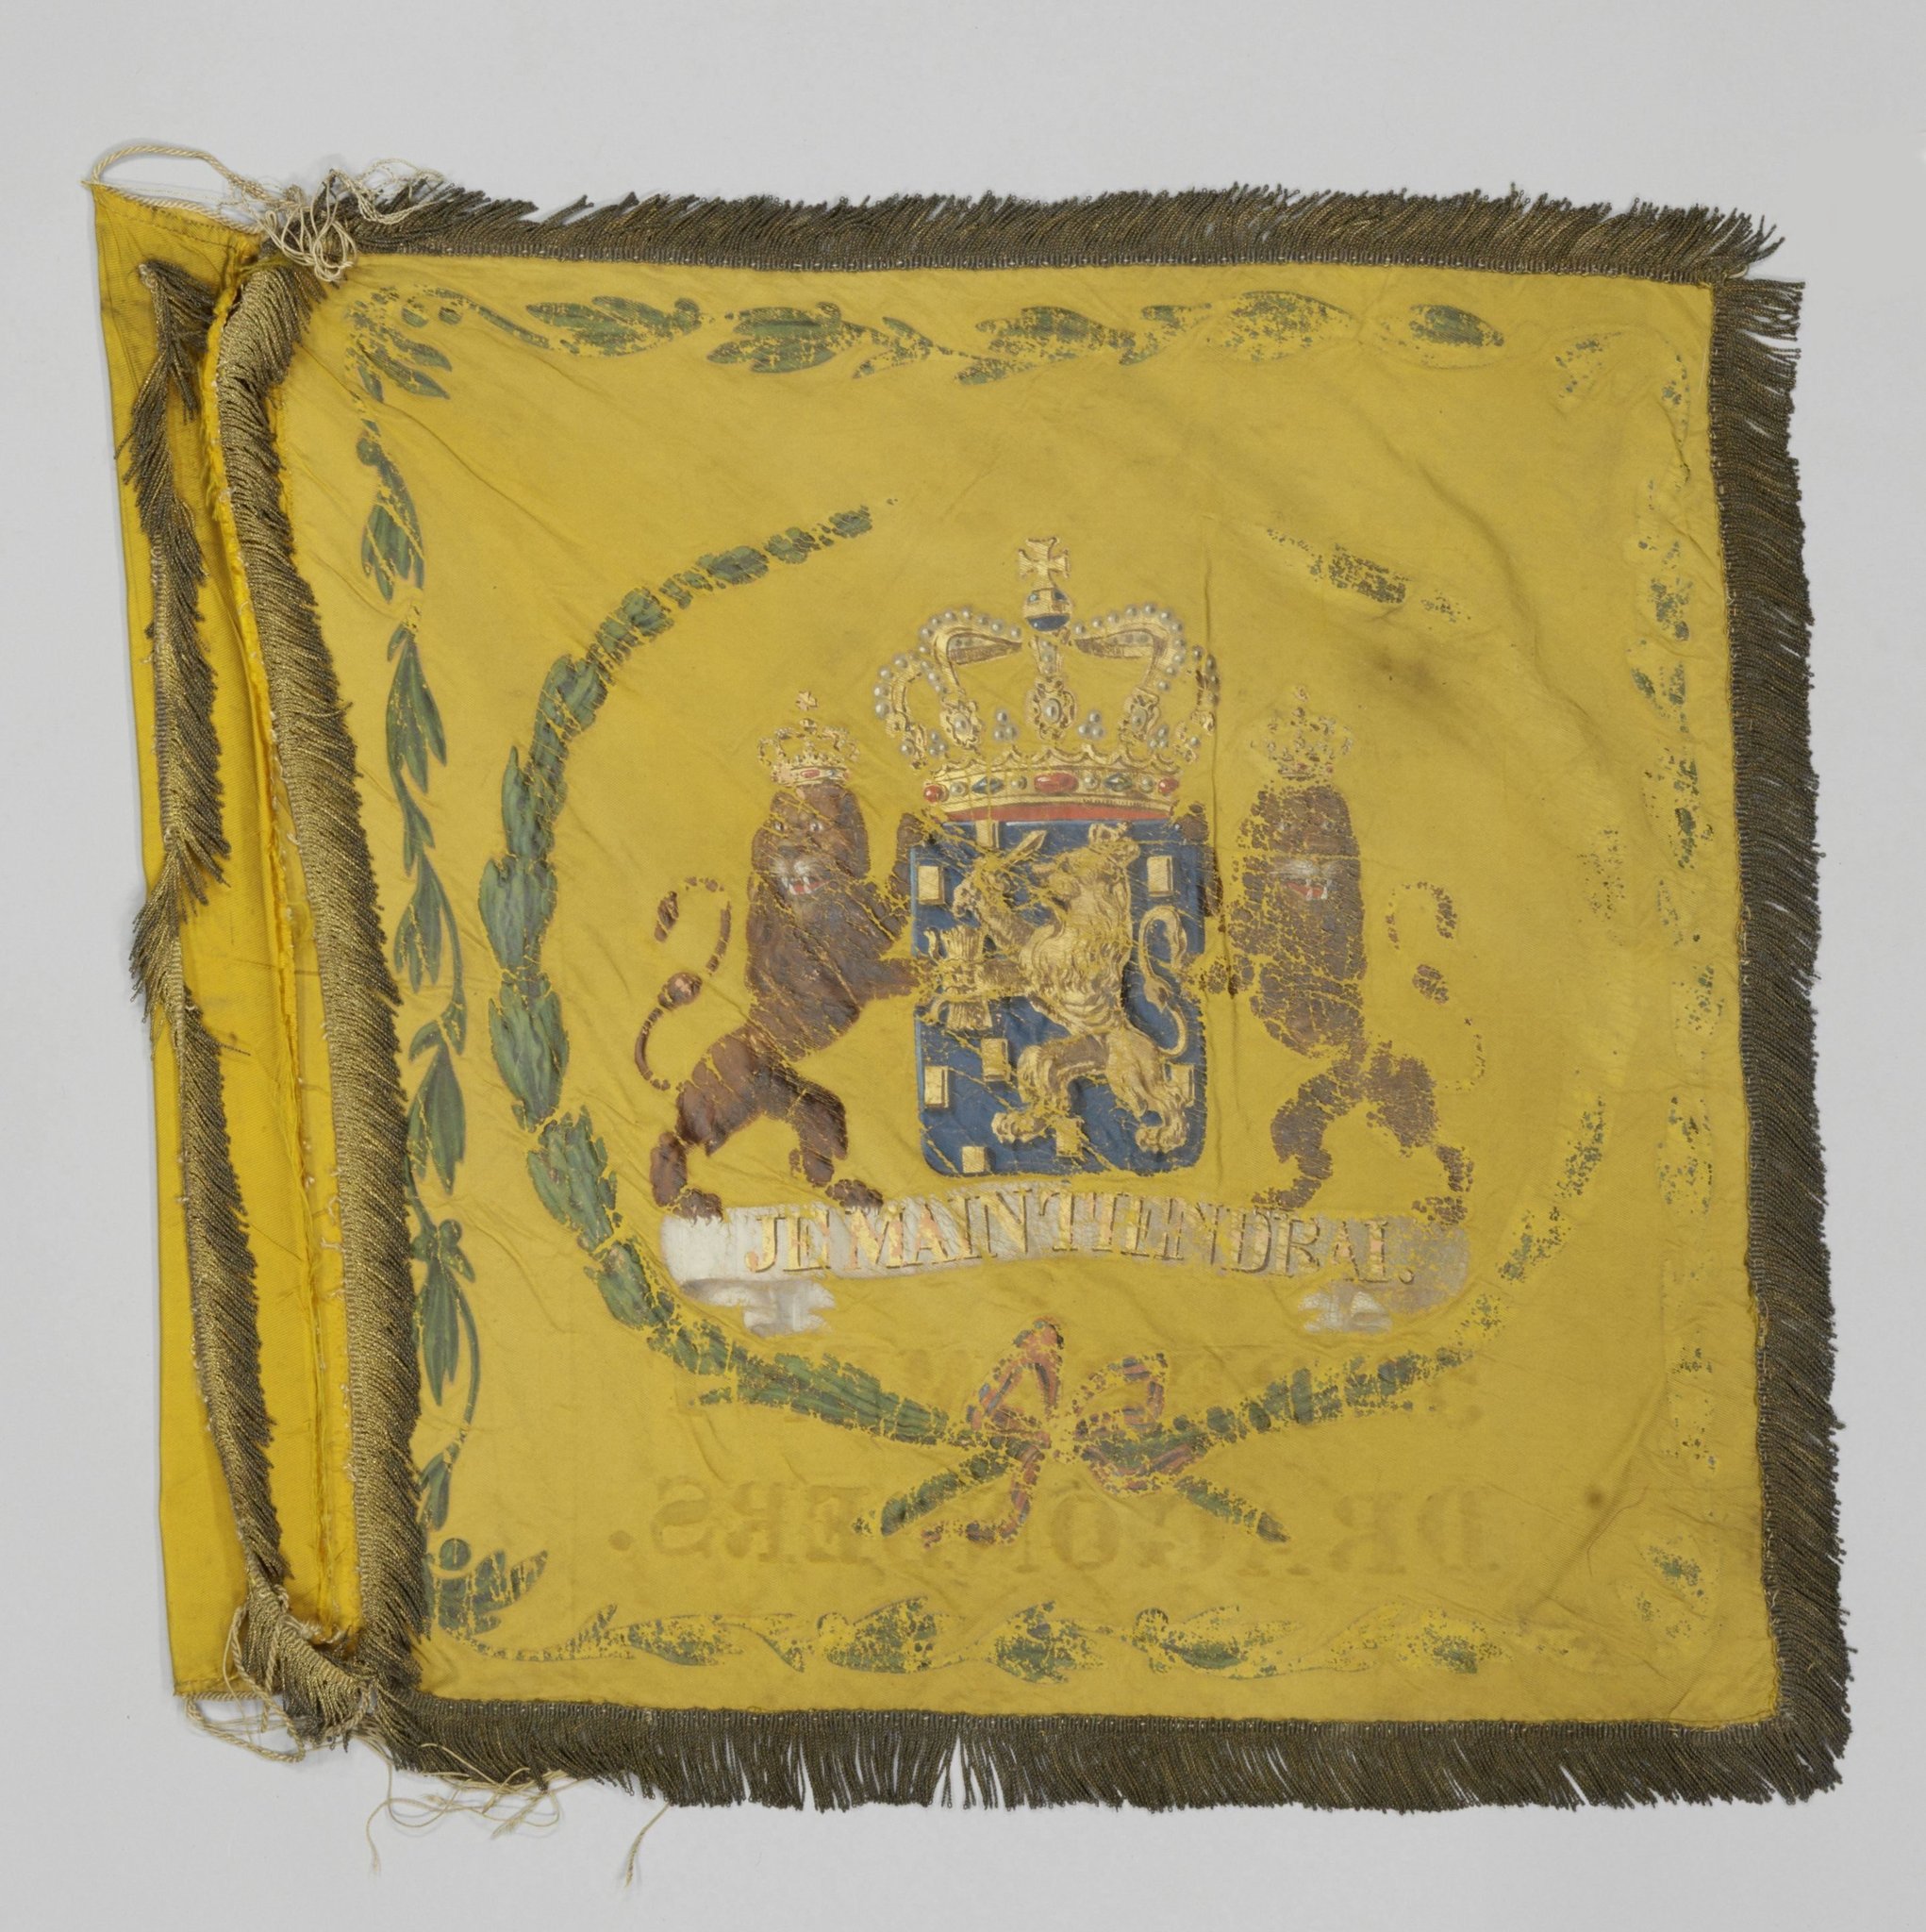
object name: standaard identificatiedrager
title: Standaard van het vijfde regiment dragonders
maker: Anonymous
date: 1846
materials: paint, silk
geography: netherlands